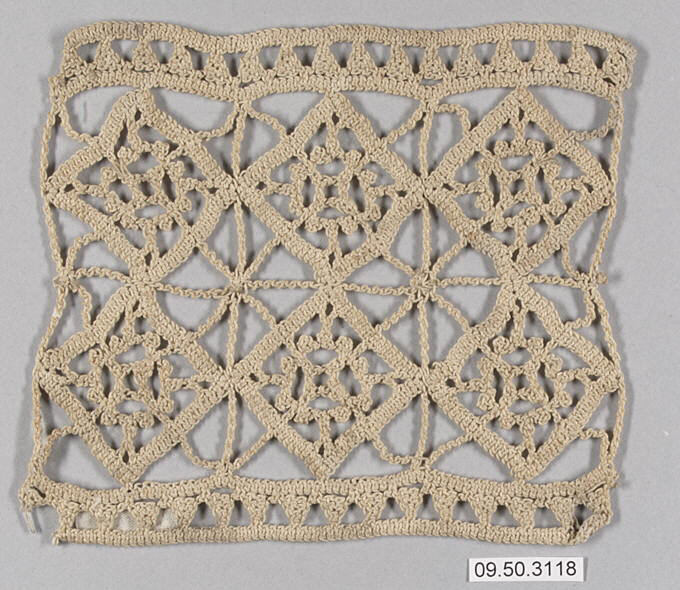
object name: piece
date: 1801-1900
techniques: crochet